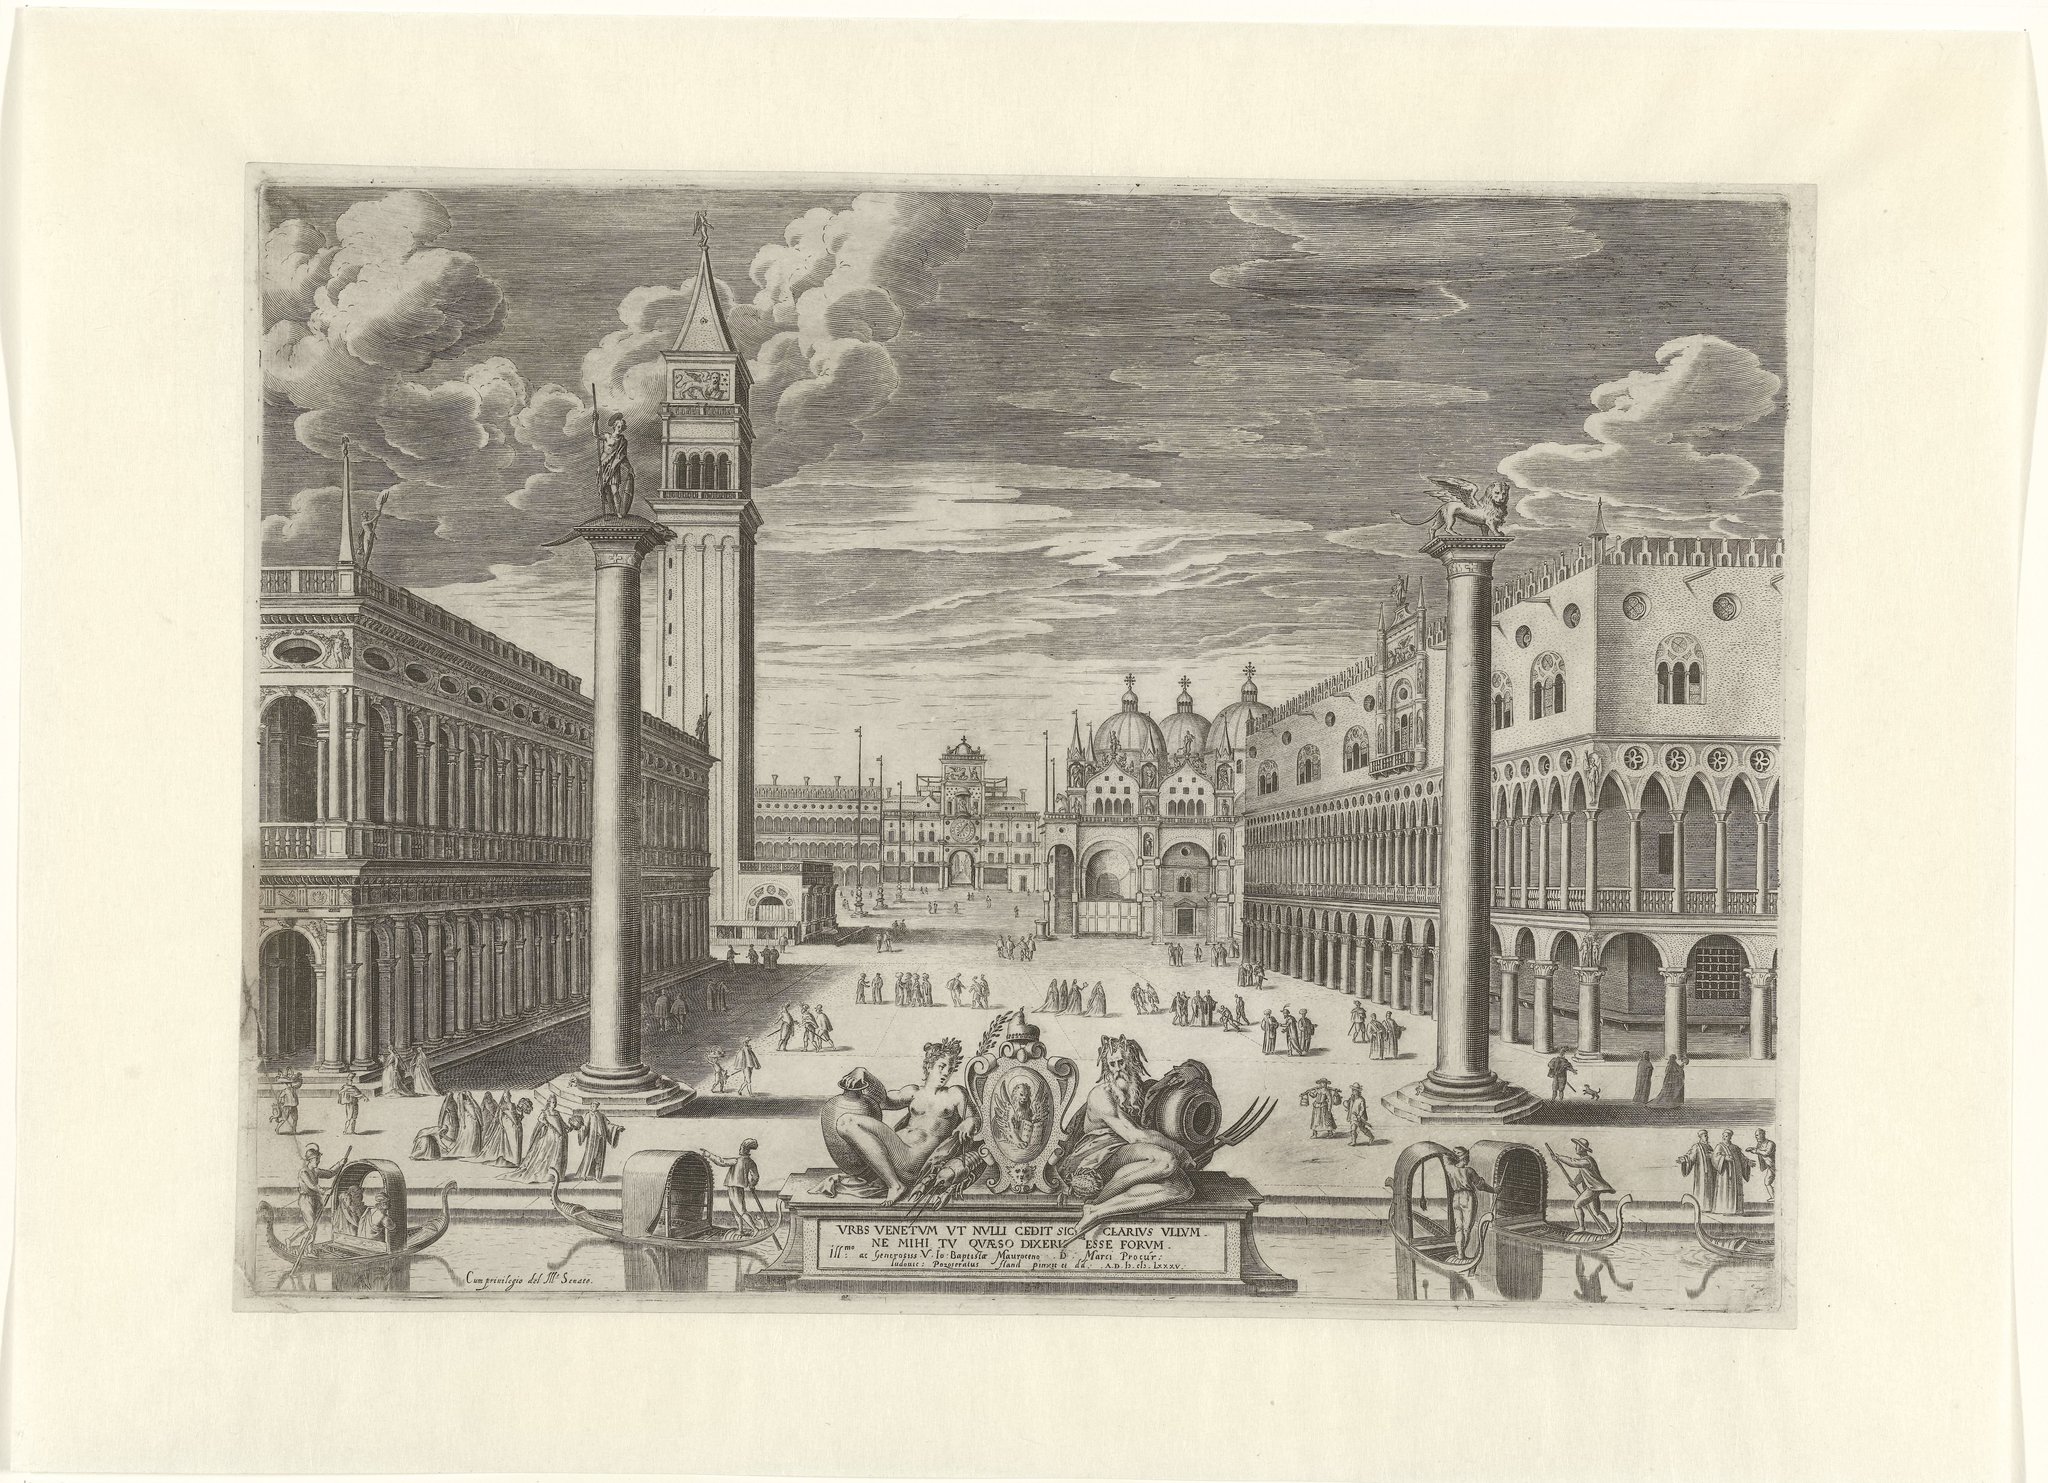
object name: print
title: Gezicht op Piazzetta te Venetië, 1585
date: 1590-1632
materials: paper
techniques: engraving, etching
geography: netherlands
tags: river-gods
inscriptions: collector's mark: Lugt 2760, collector's mark: Lugt 2228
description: Gezicht op het Piazzetta (het deel van het Piazza San Marco tussen het Palazzo Ducale en de Biblioteca Marcianate) te Venetië, in 1585. Op het plein diverse figuren en de twee zuilen met het standbeeld van de Heilige Teodoro van Amasea en de leeuw van Marcus. Midden voor het wapenschild van de stad Venetië op een piëdestal, geflankeerd door een riviergod en een riviergodin. In het kader op de piëdestal vier regels in het Latijn.